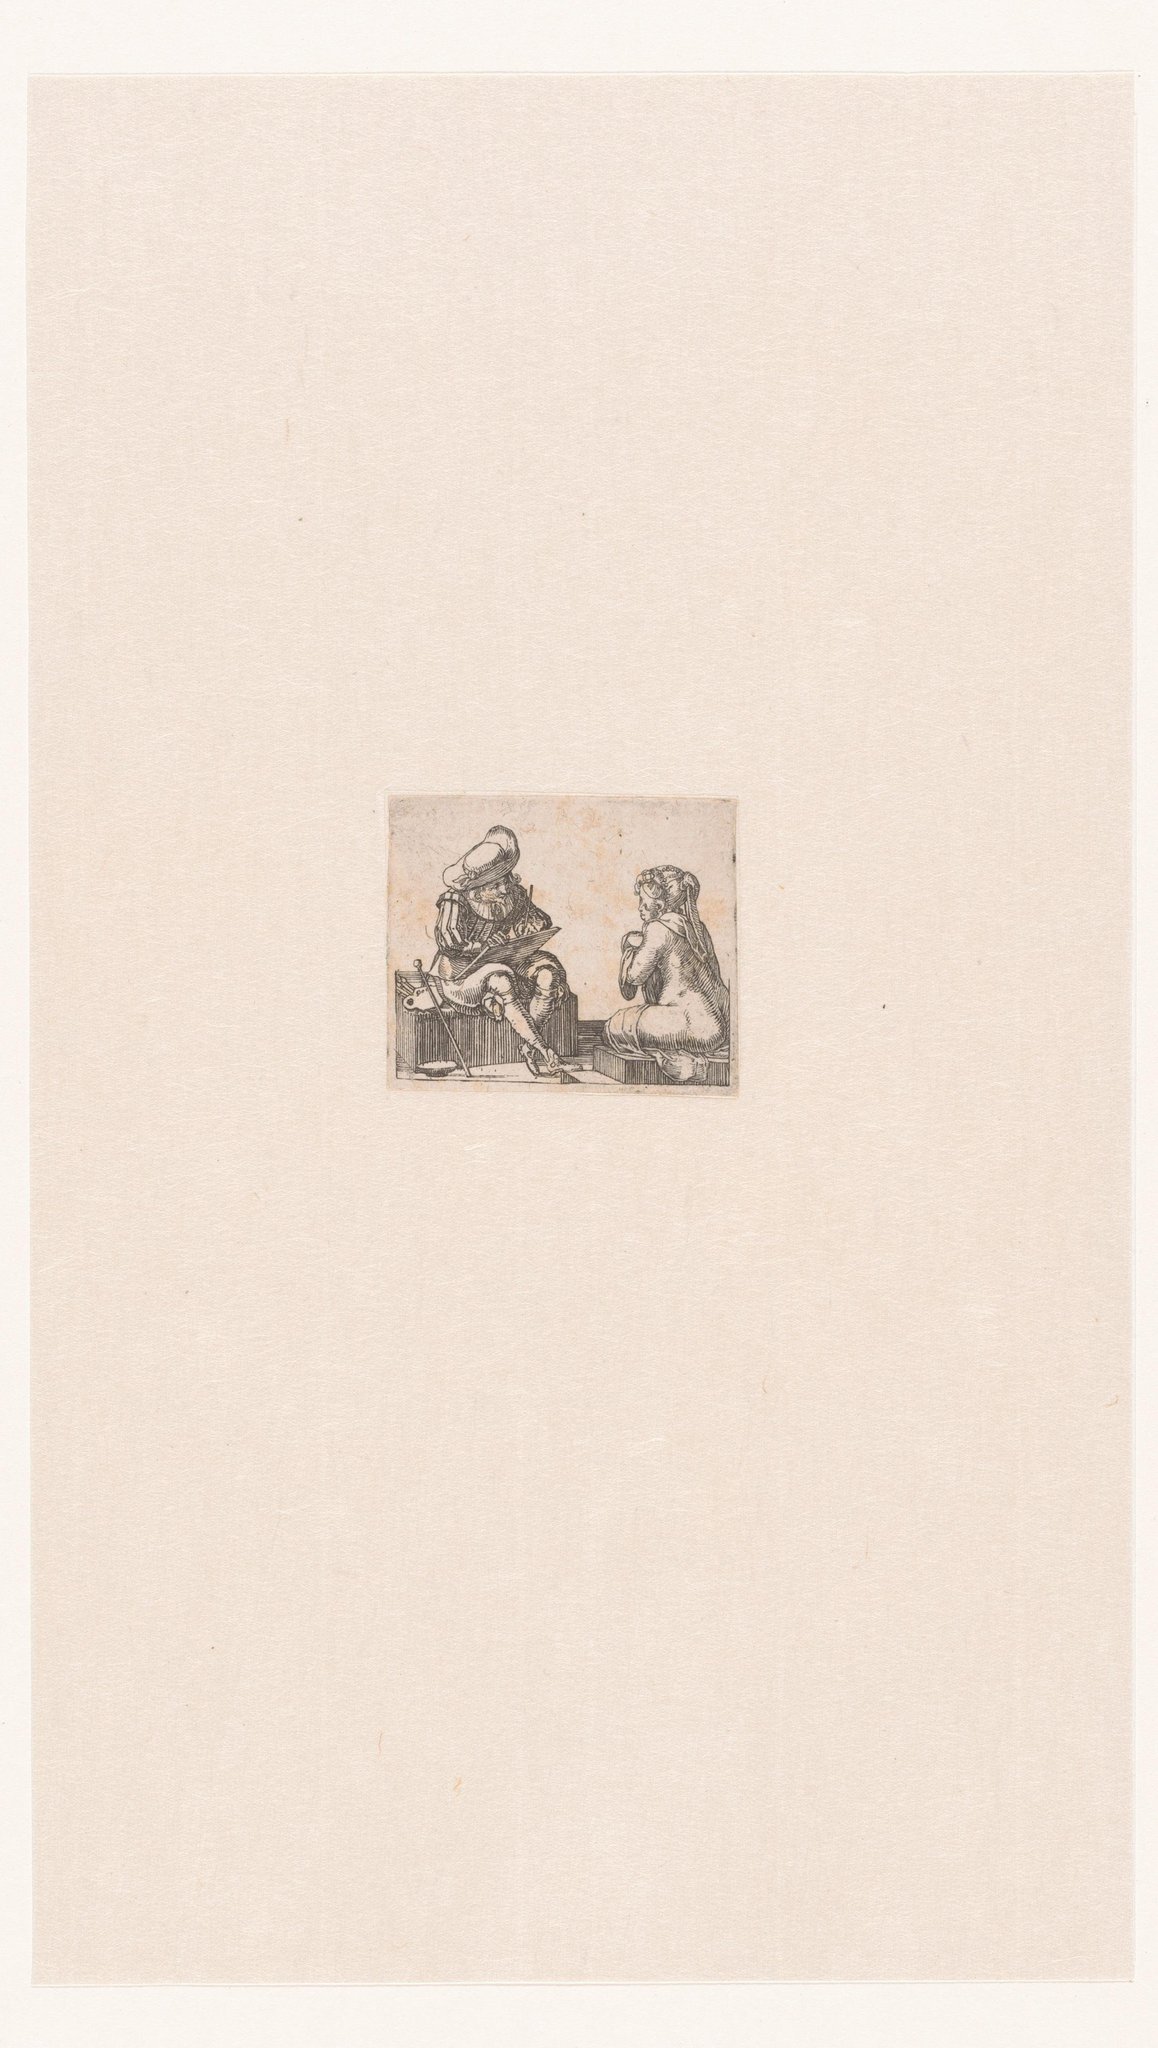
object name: print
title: De schilder met zijn model in zijn atelier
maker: rudolph meyer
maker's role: print maker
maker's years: 1605-1638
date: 1615-1638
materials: paper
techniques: etching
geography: zurich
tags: artist (in general) working from nude model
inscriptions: collector's mark: Lugt 2228